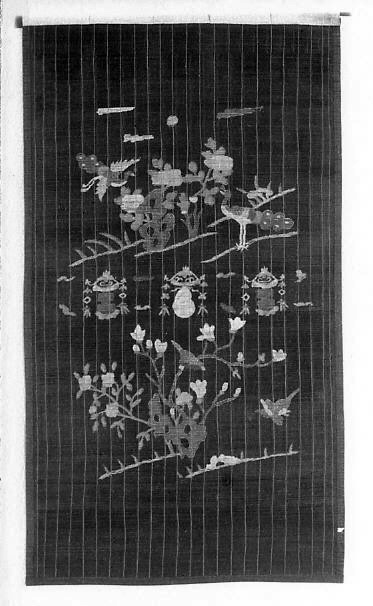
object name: blind with covered box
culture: chinese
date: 1701-1900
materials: bamboo, cotton, paint, silk, wood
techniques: lacquer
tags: peacocks,plants